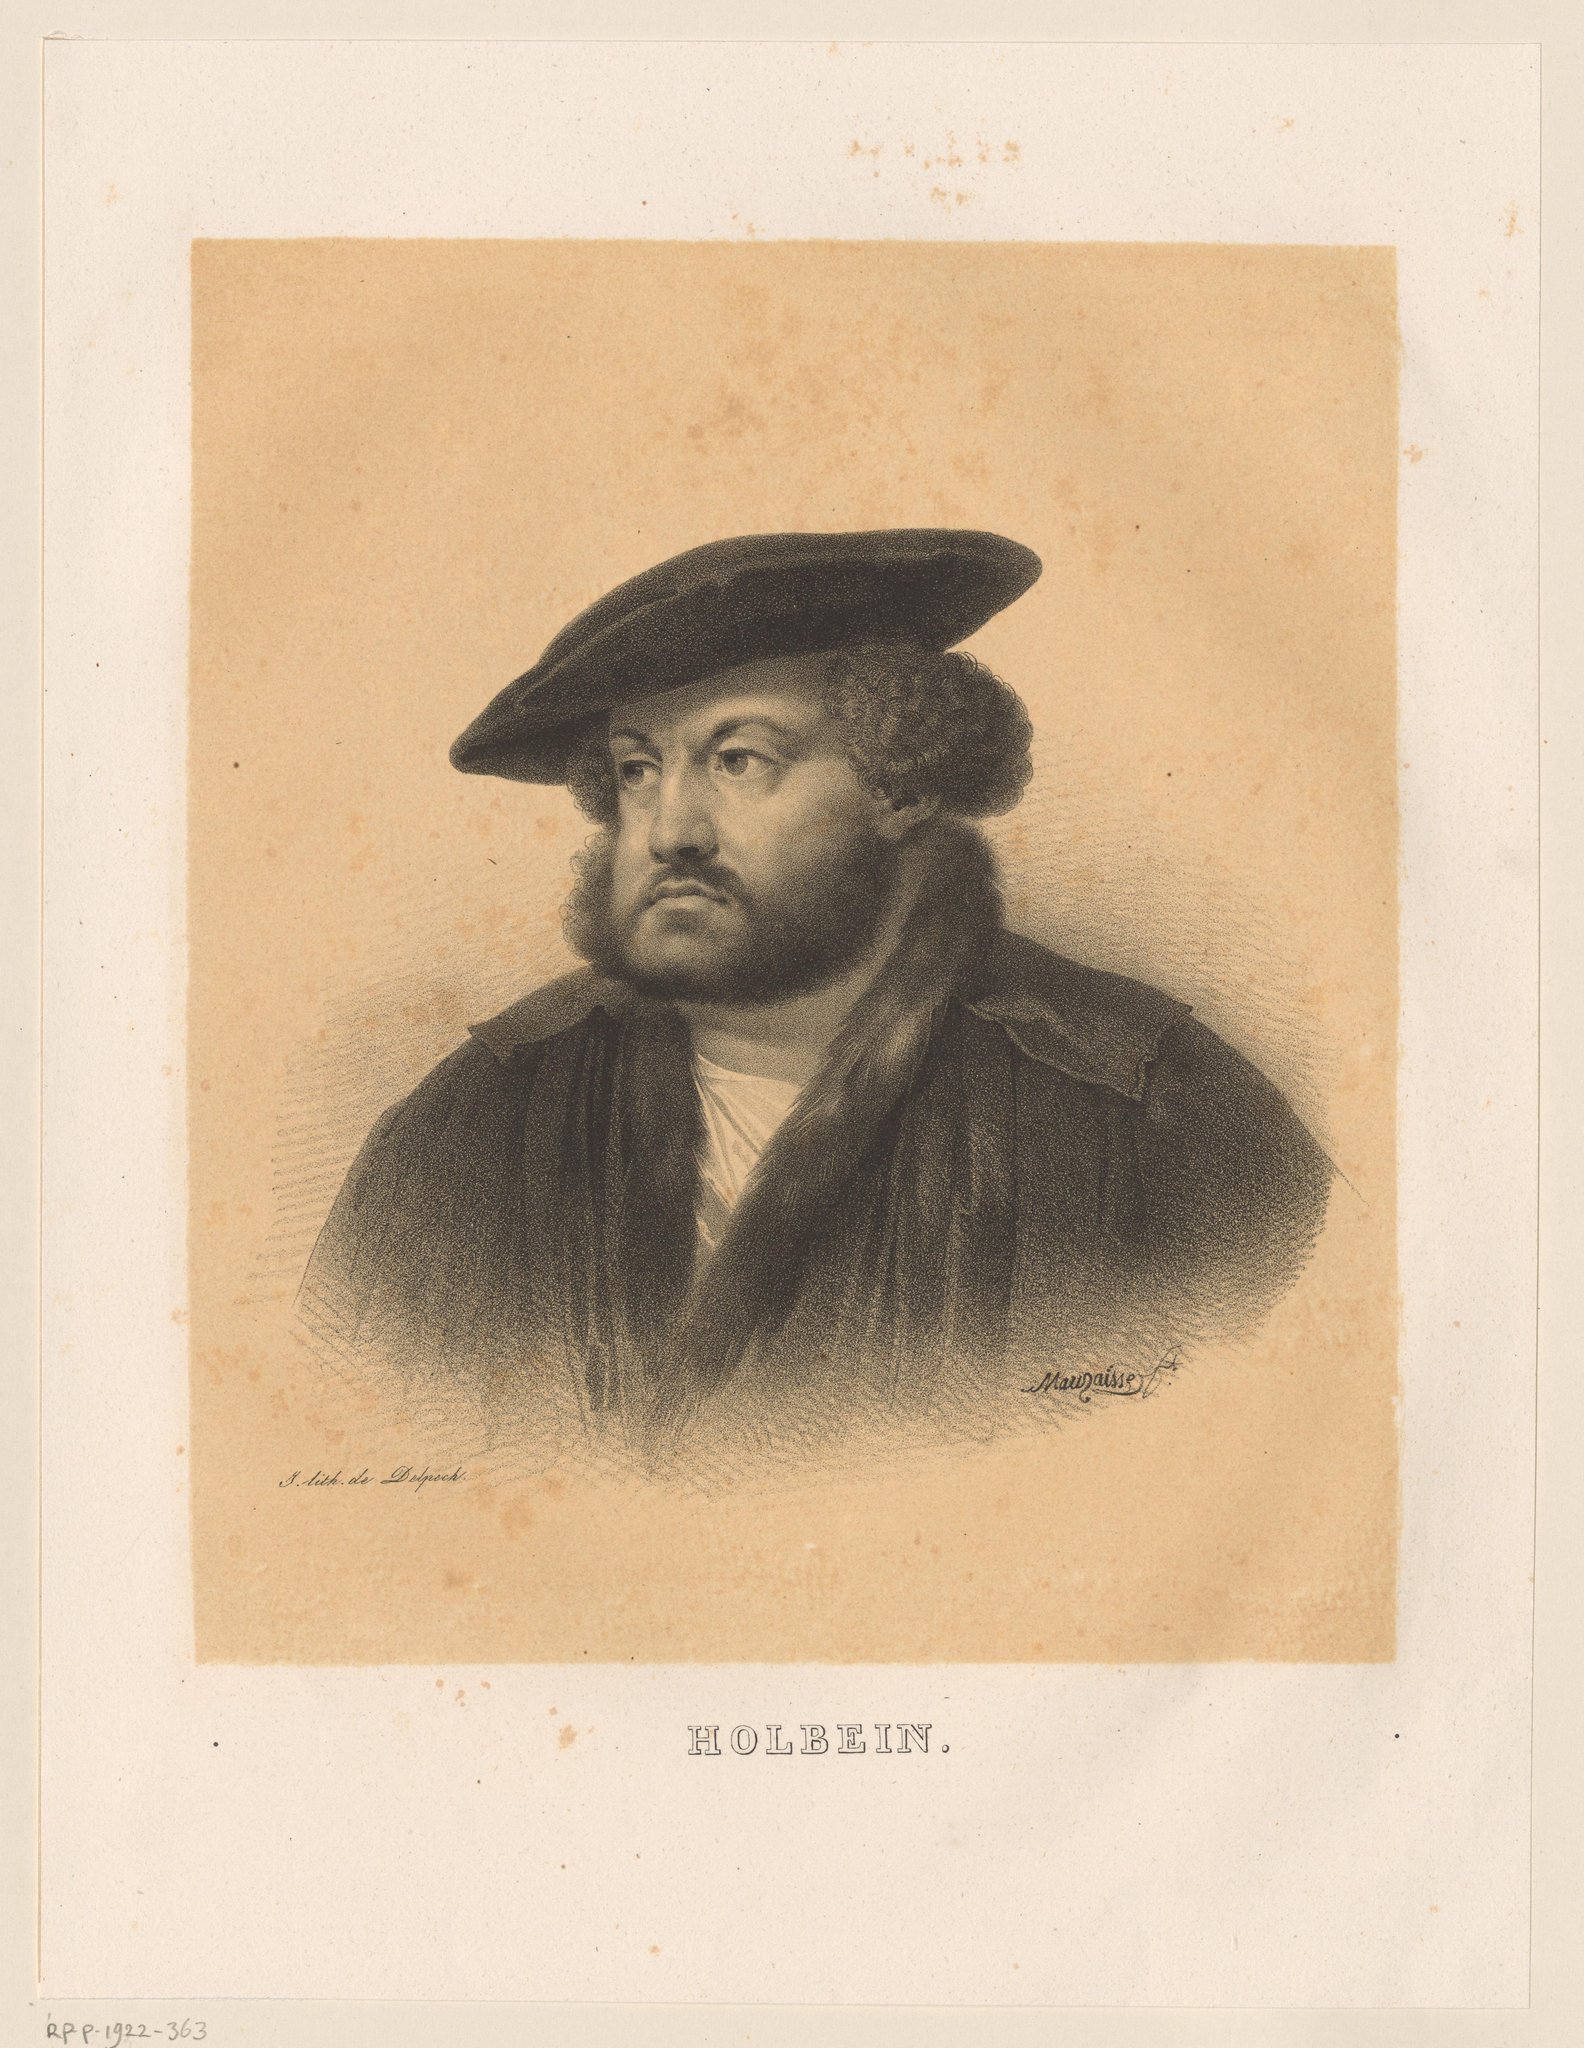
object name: print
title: Portret van Hans Holbein II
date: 1822-1834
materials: paper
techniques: tone lithography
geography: paris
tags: augsburg, london, draughtsman, hans holbein (ii), head-gear, historical persons, portrait, self-portrait of painter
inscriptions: collector's mark: Lugt 2233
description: Prent uit: Chabert, Jean Claude. Galerie des peintres ou collection de portraits des peintres les plus célèbres de toutes les écoles. Accompagnée d'une notice sur chacun d'eux, et de copies de dessins originaux / Galerie des peintres ou collection de portraits des peintres les plus célèbres de toutes les écoles. Accompagnée de leur notice historique, de leurs dessins et d'un discours sur les arts. Parijs: Jean Claude Chabert, [1822-1834]. De samenstelling van tegenwoordig bekende en al dan niet gebonden exemplaren van deze uitgave verschilt. Dit omdat de prenten en bijhorende stukken tekst op inschrijving en waarschijnlijk ook los verkrijgbaar waren.